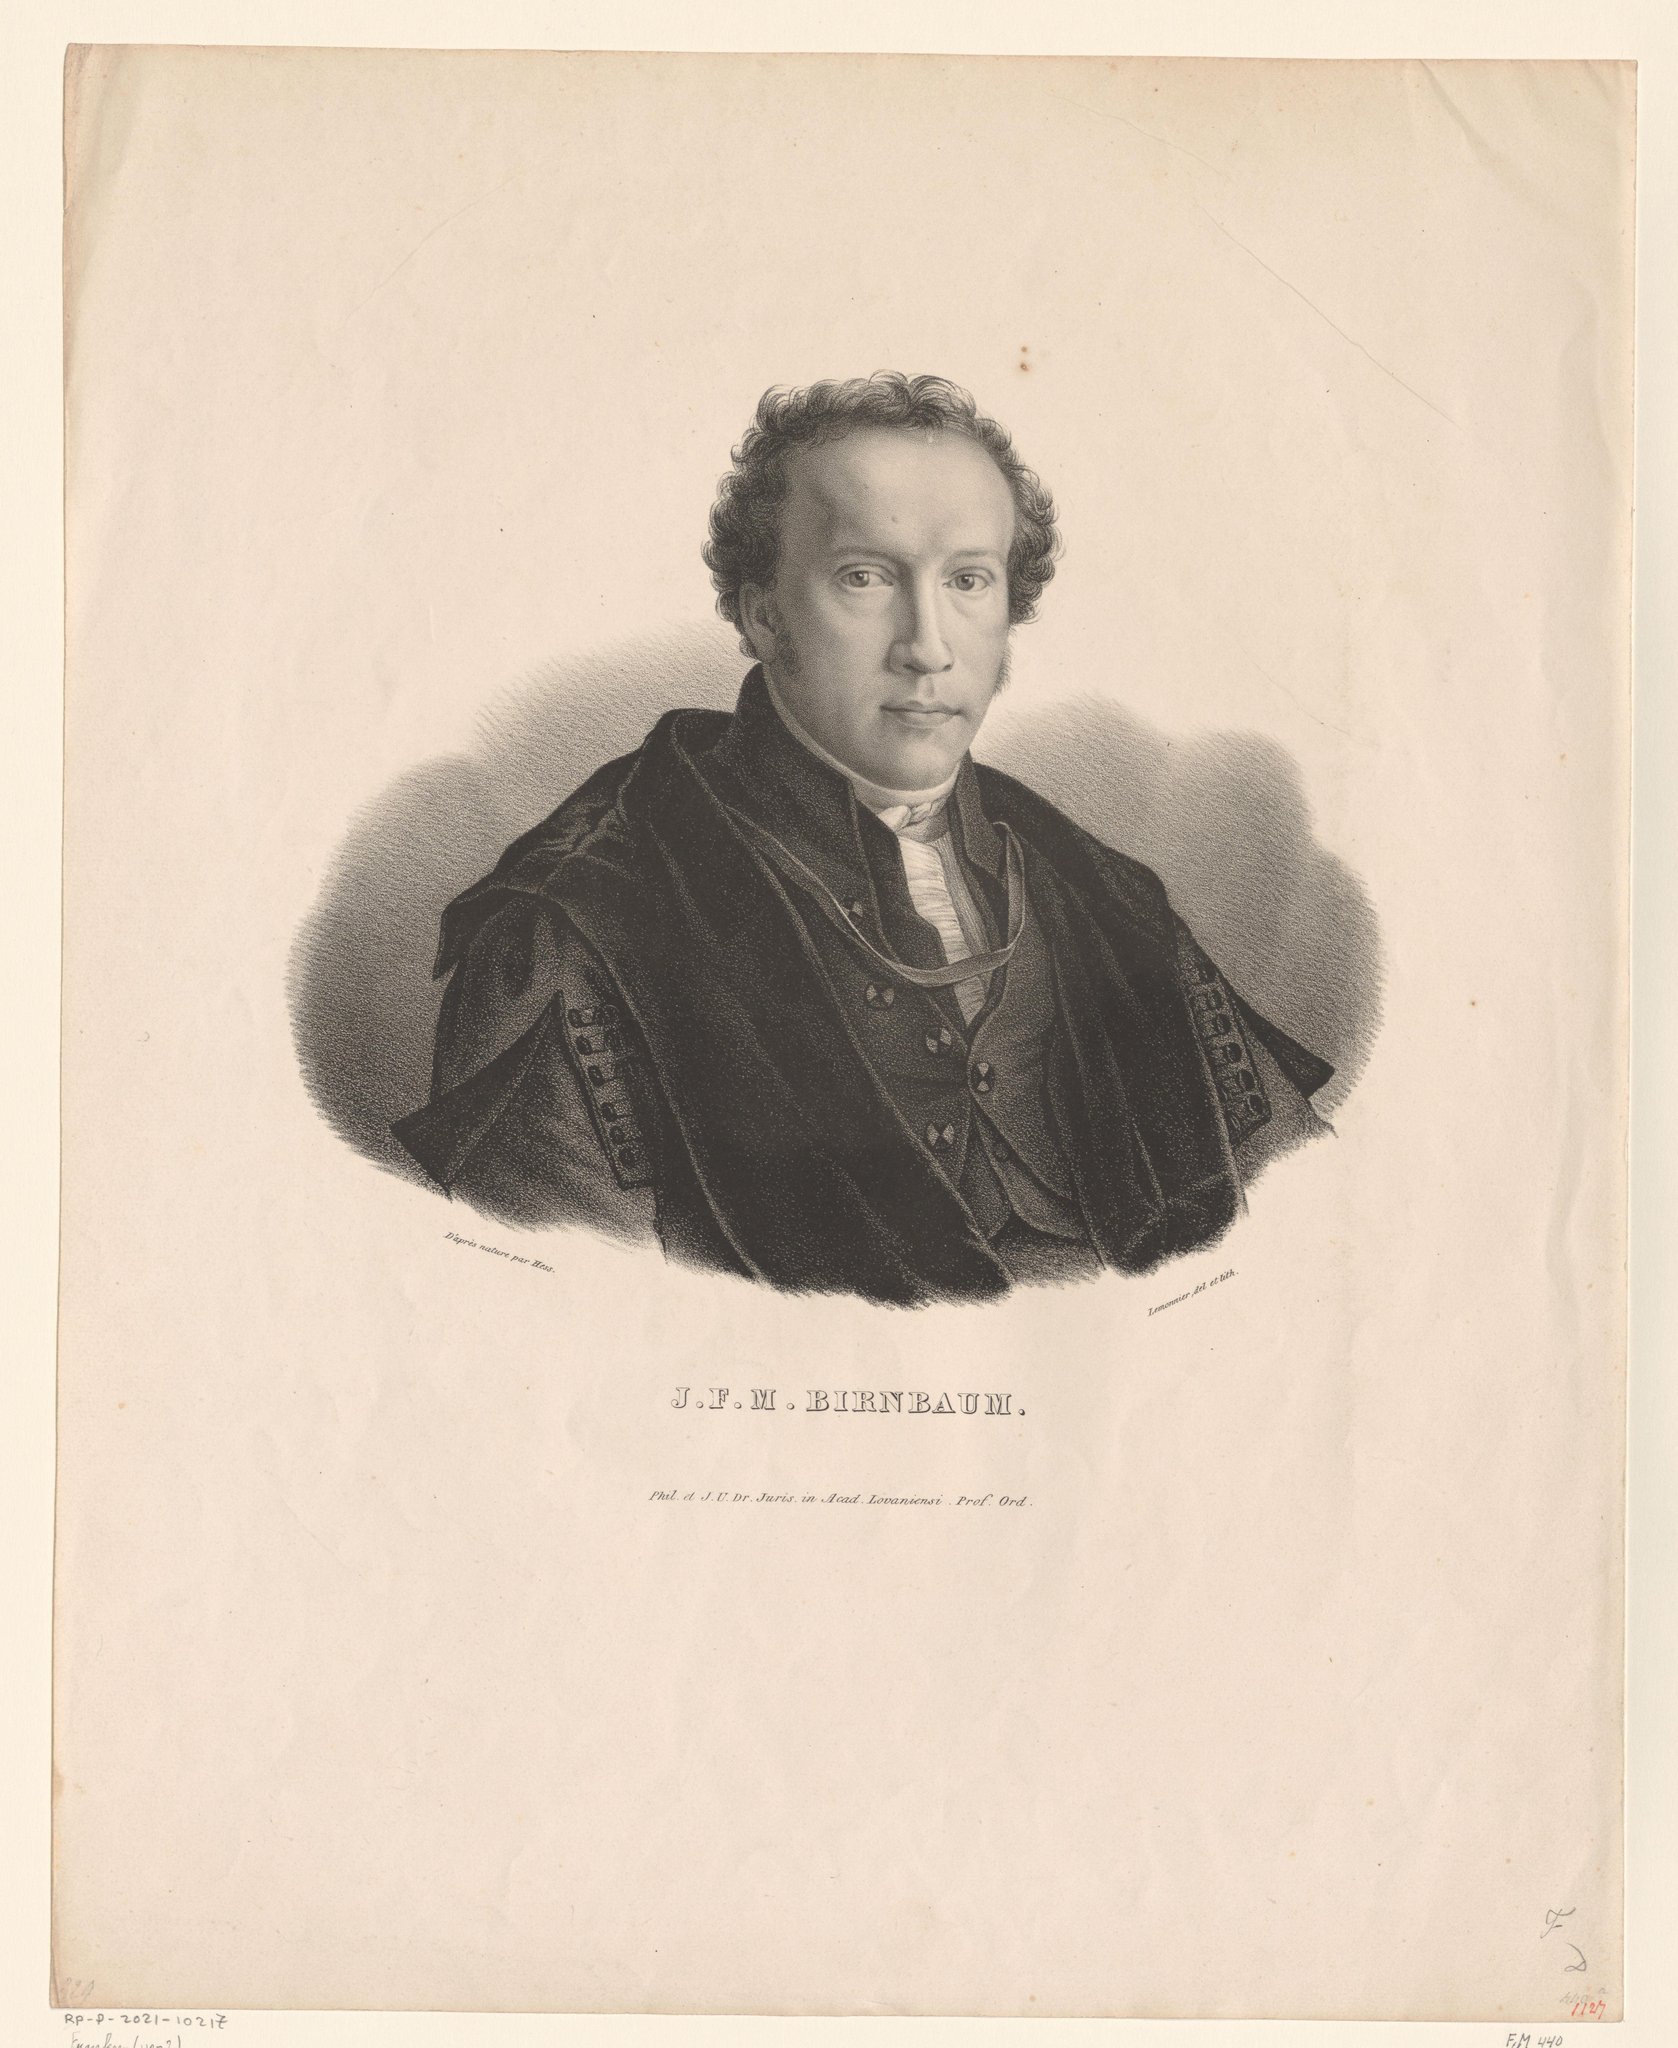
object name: print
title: Portret van Johann Michael Franz Birnbaum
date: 1825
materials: paper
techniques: lithograph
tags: historical persons, professor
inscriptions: collector's mark: Lugt 2228